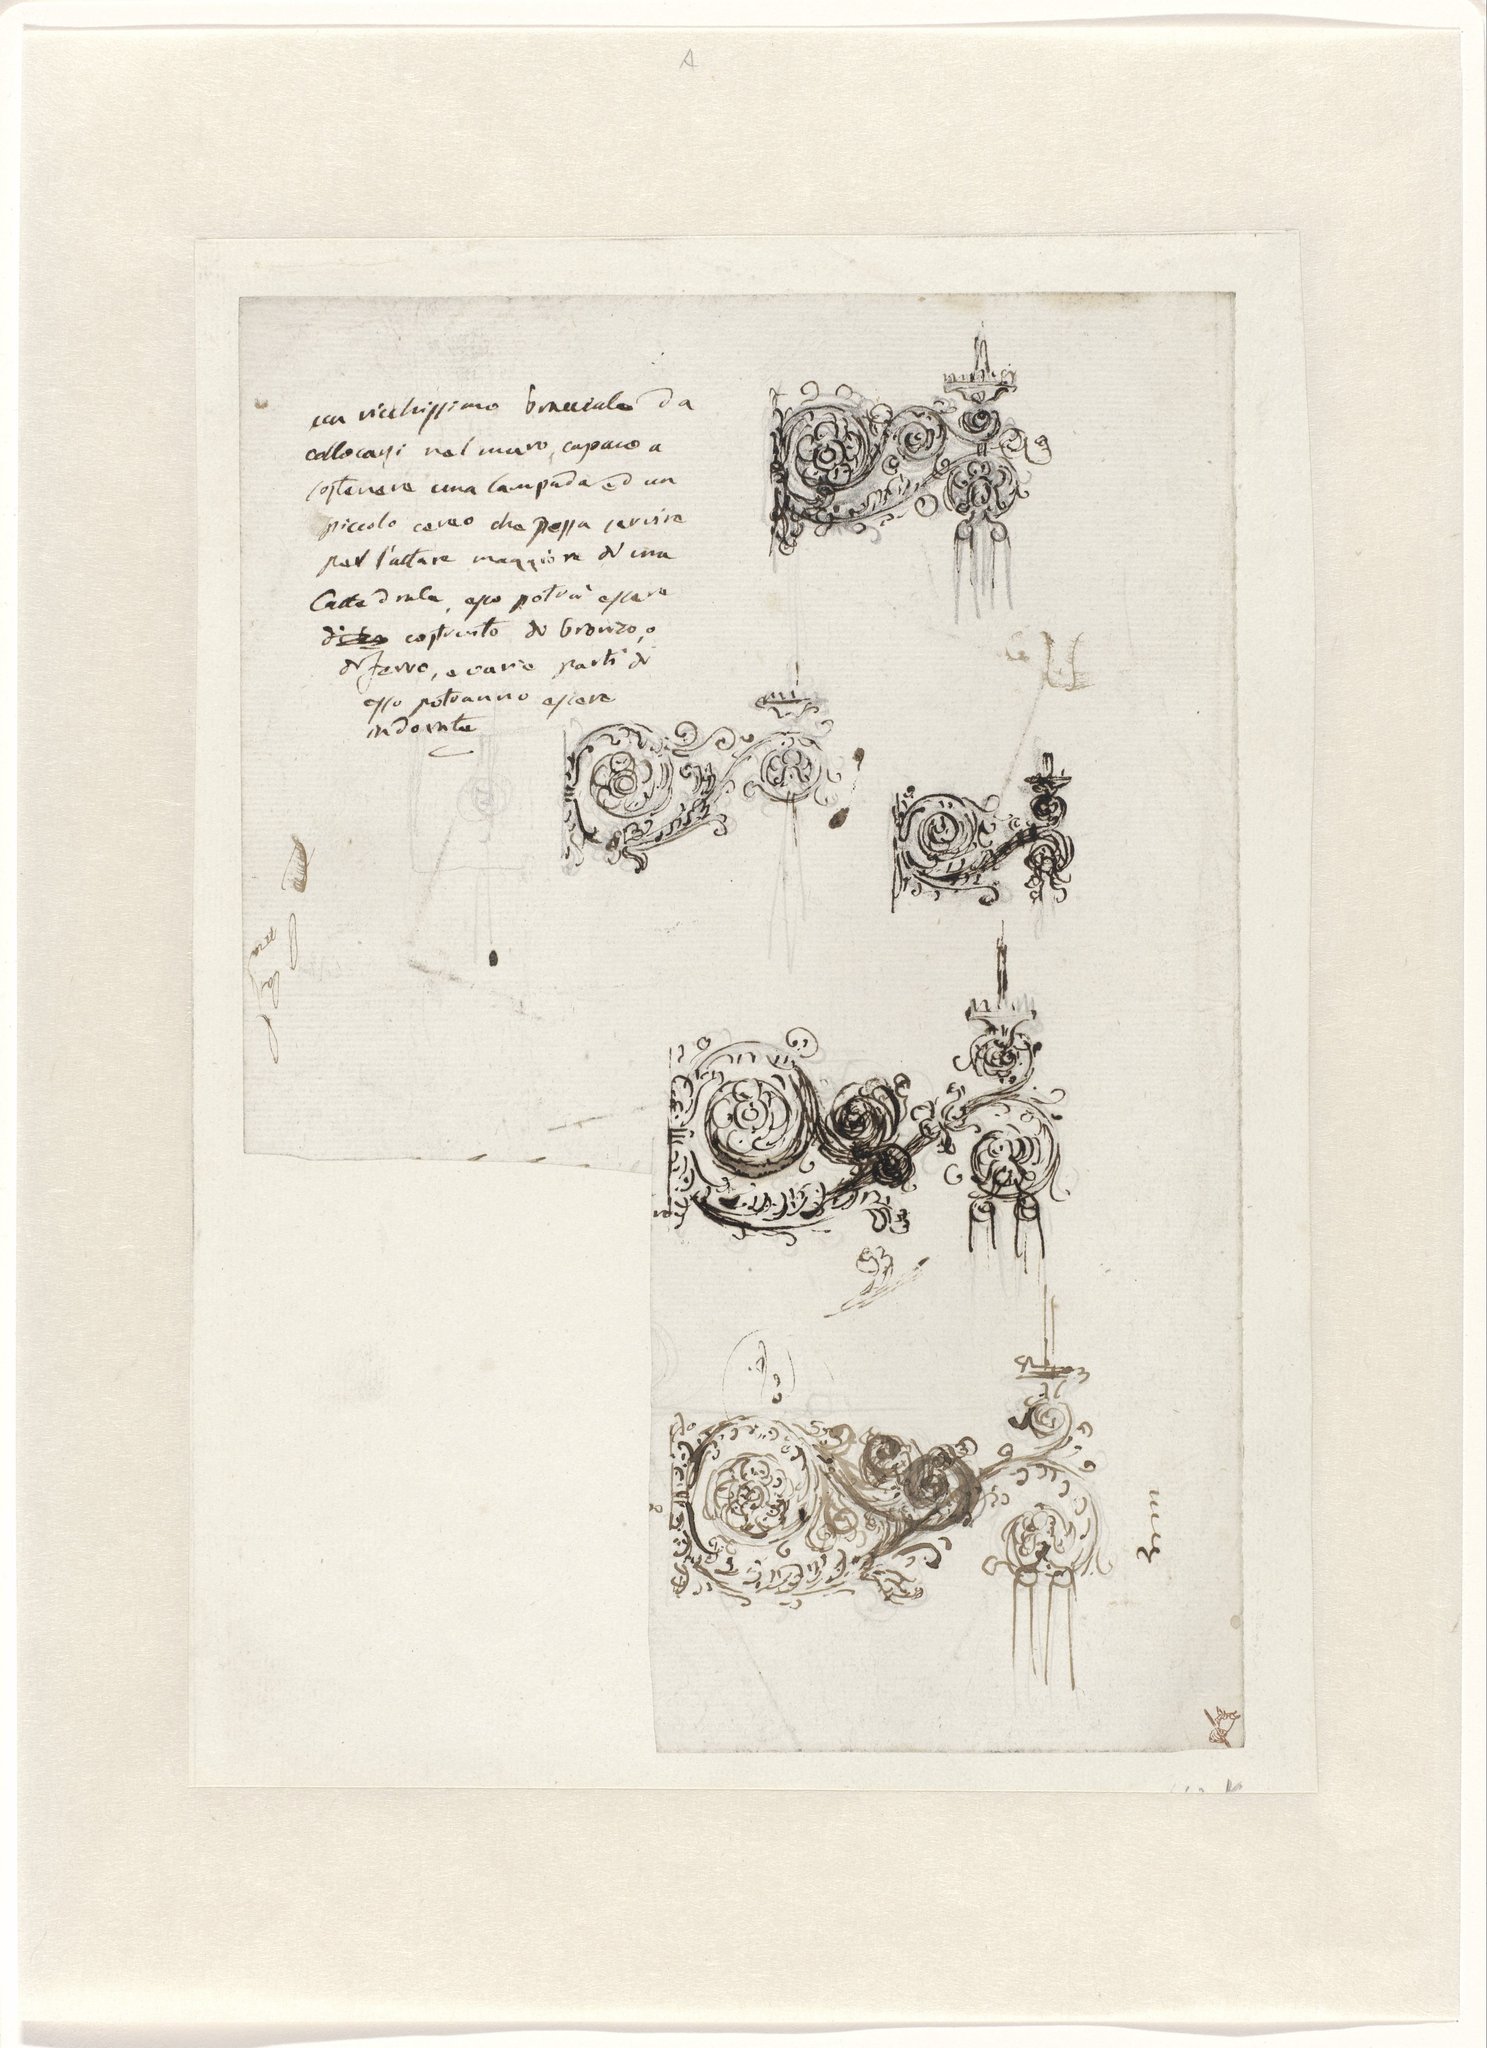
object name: design drawing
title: Ontwerp voor wandarm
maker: Anonymous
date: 1820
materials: graphite, ink, paper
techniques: brush, pen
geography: northern italy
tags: sconce, wall lamp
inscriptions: collector's mark: Lugt 3893, watermark:, inscription: ‘un richissimo braccialo da / collocarsi nal muro, capace a / sostenere una lampada ed un / piccolo caveo che possa servire / per l'altare maggiore di una / Cattedrale esso pootrà essere / costruito di bronzo, o / di ferro, e varie parte di / esso potranno essere / indorate’